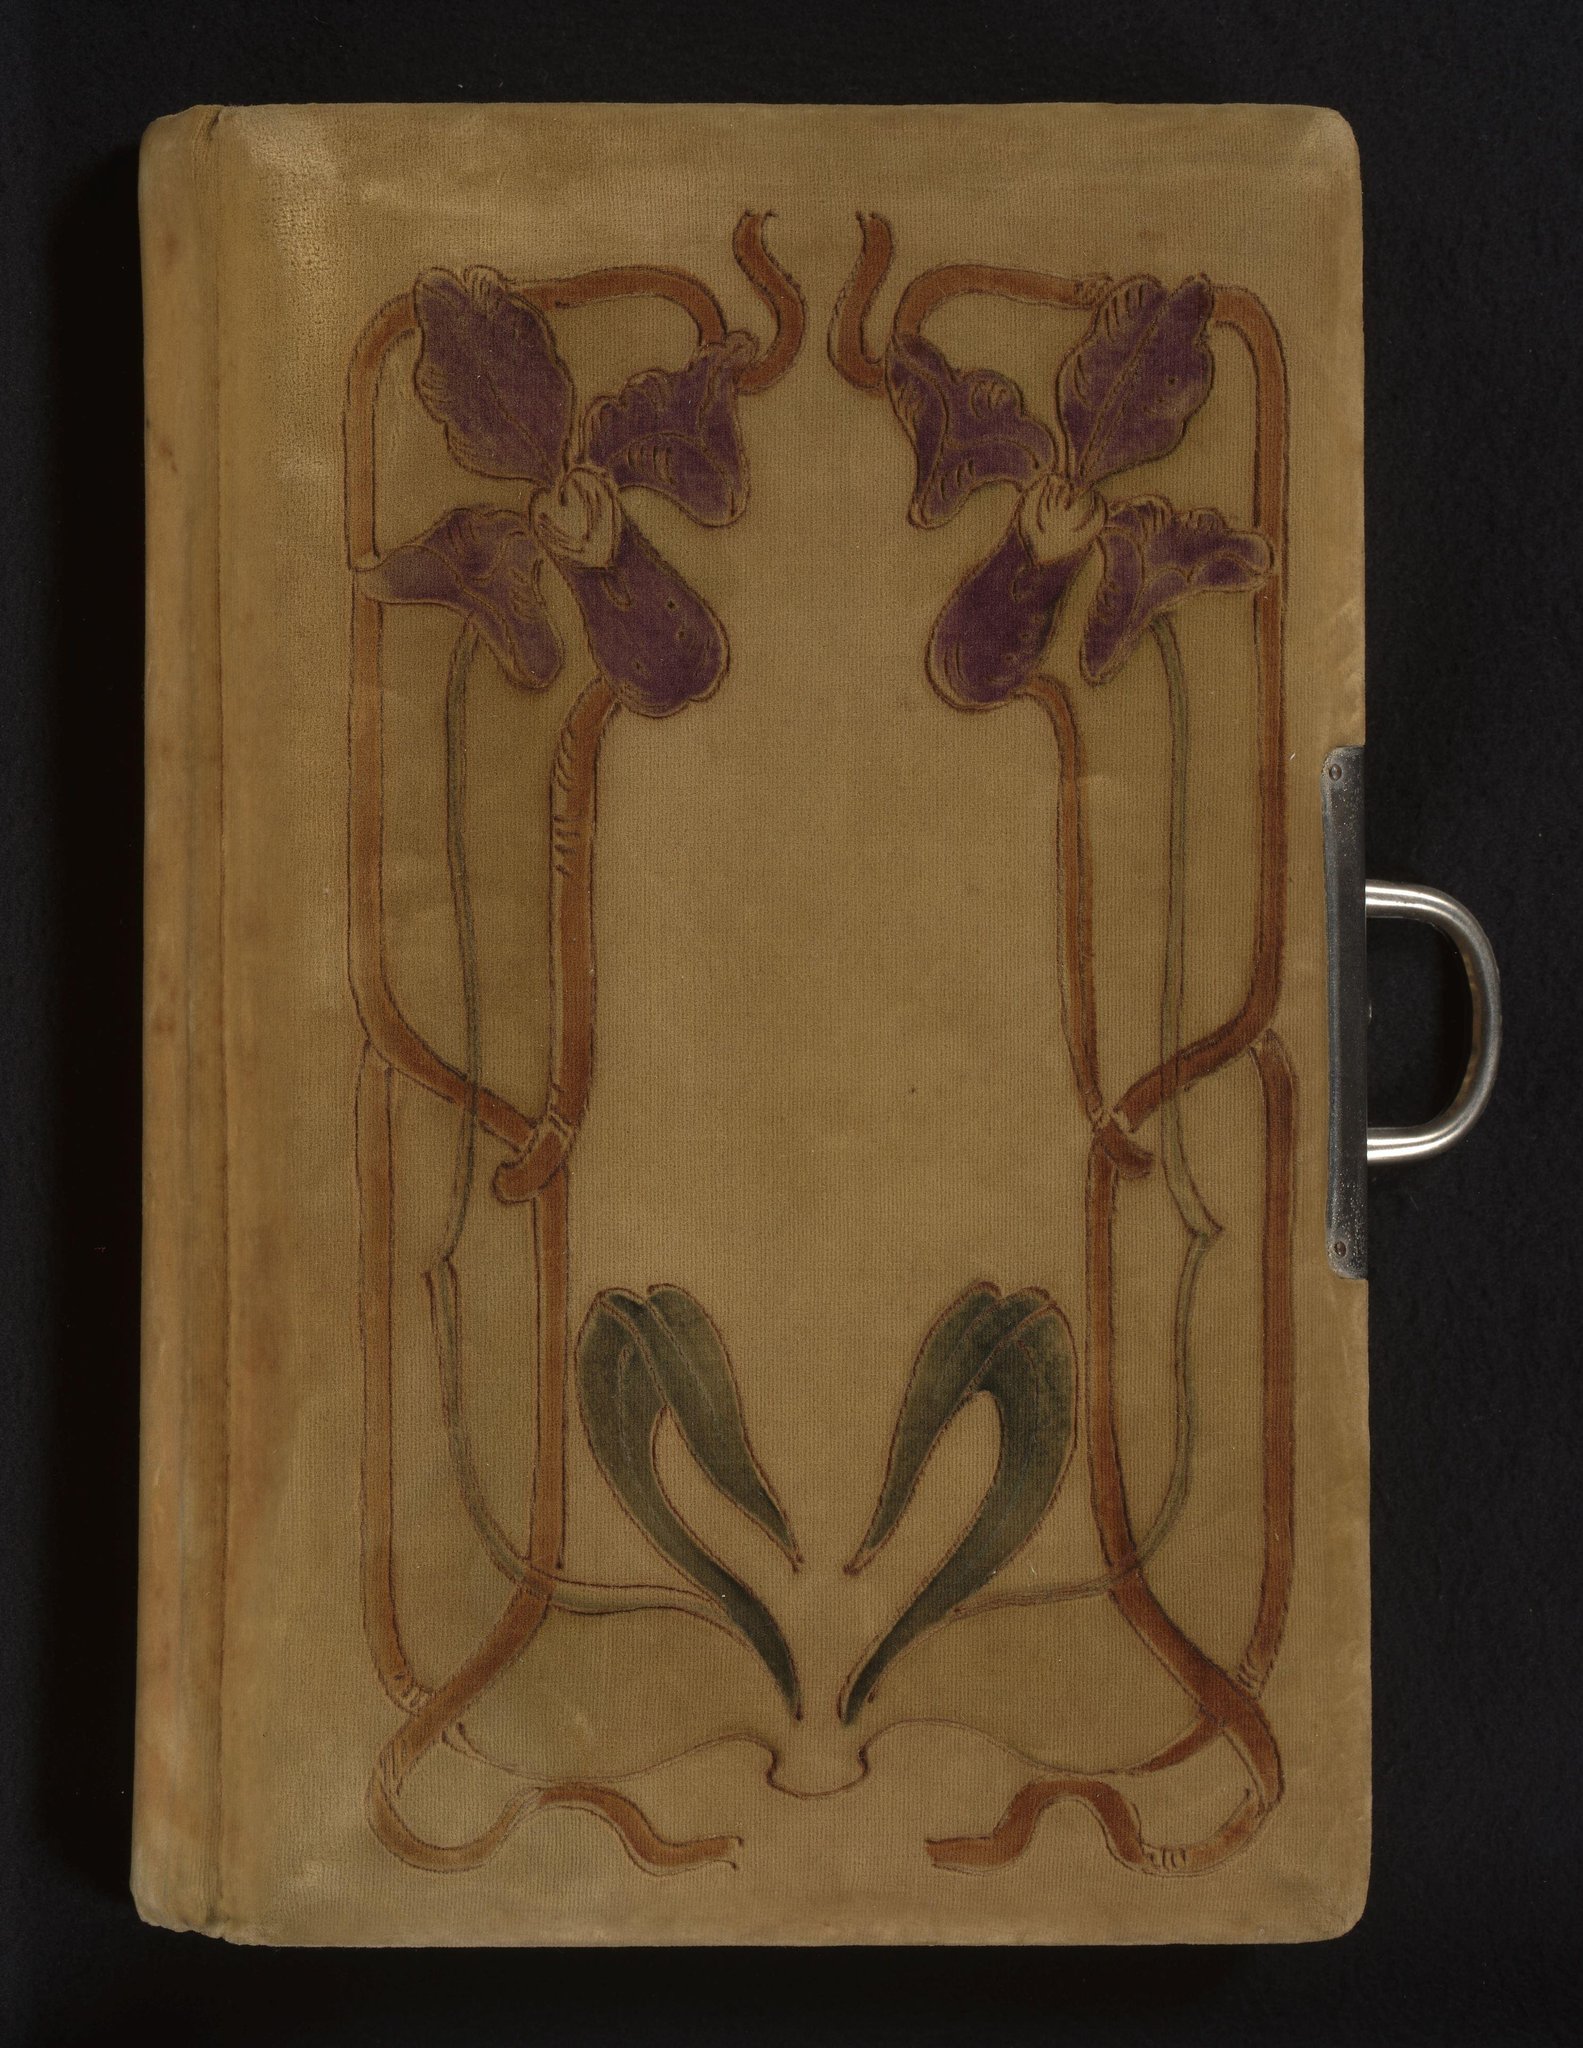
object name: slip in album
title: Fotoalbum (leeg)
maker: Anonymous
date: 1860-1900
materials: cardboard, metal, paper, textile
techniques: decorated paper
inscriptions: collector's mark: ‘DIENST/ VERSPREIDE/ RIJKSKOLLEKTIES/ (...) A 708’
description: Fotoalbum met 28 pagina's met ofwel een met gouden lijnen omkaderde passe-partout voor een kabinetfoto, ofwel 2 met gouden lijnen omkaderde passe-partouts voor cartes-de-visite. In totaal is er in het album plaats voor 12 kabinetfoto's en 32 cartes-de-visite.